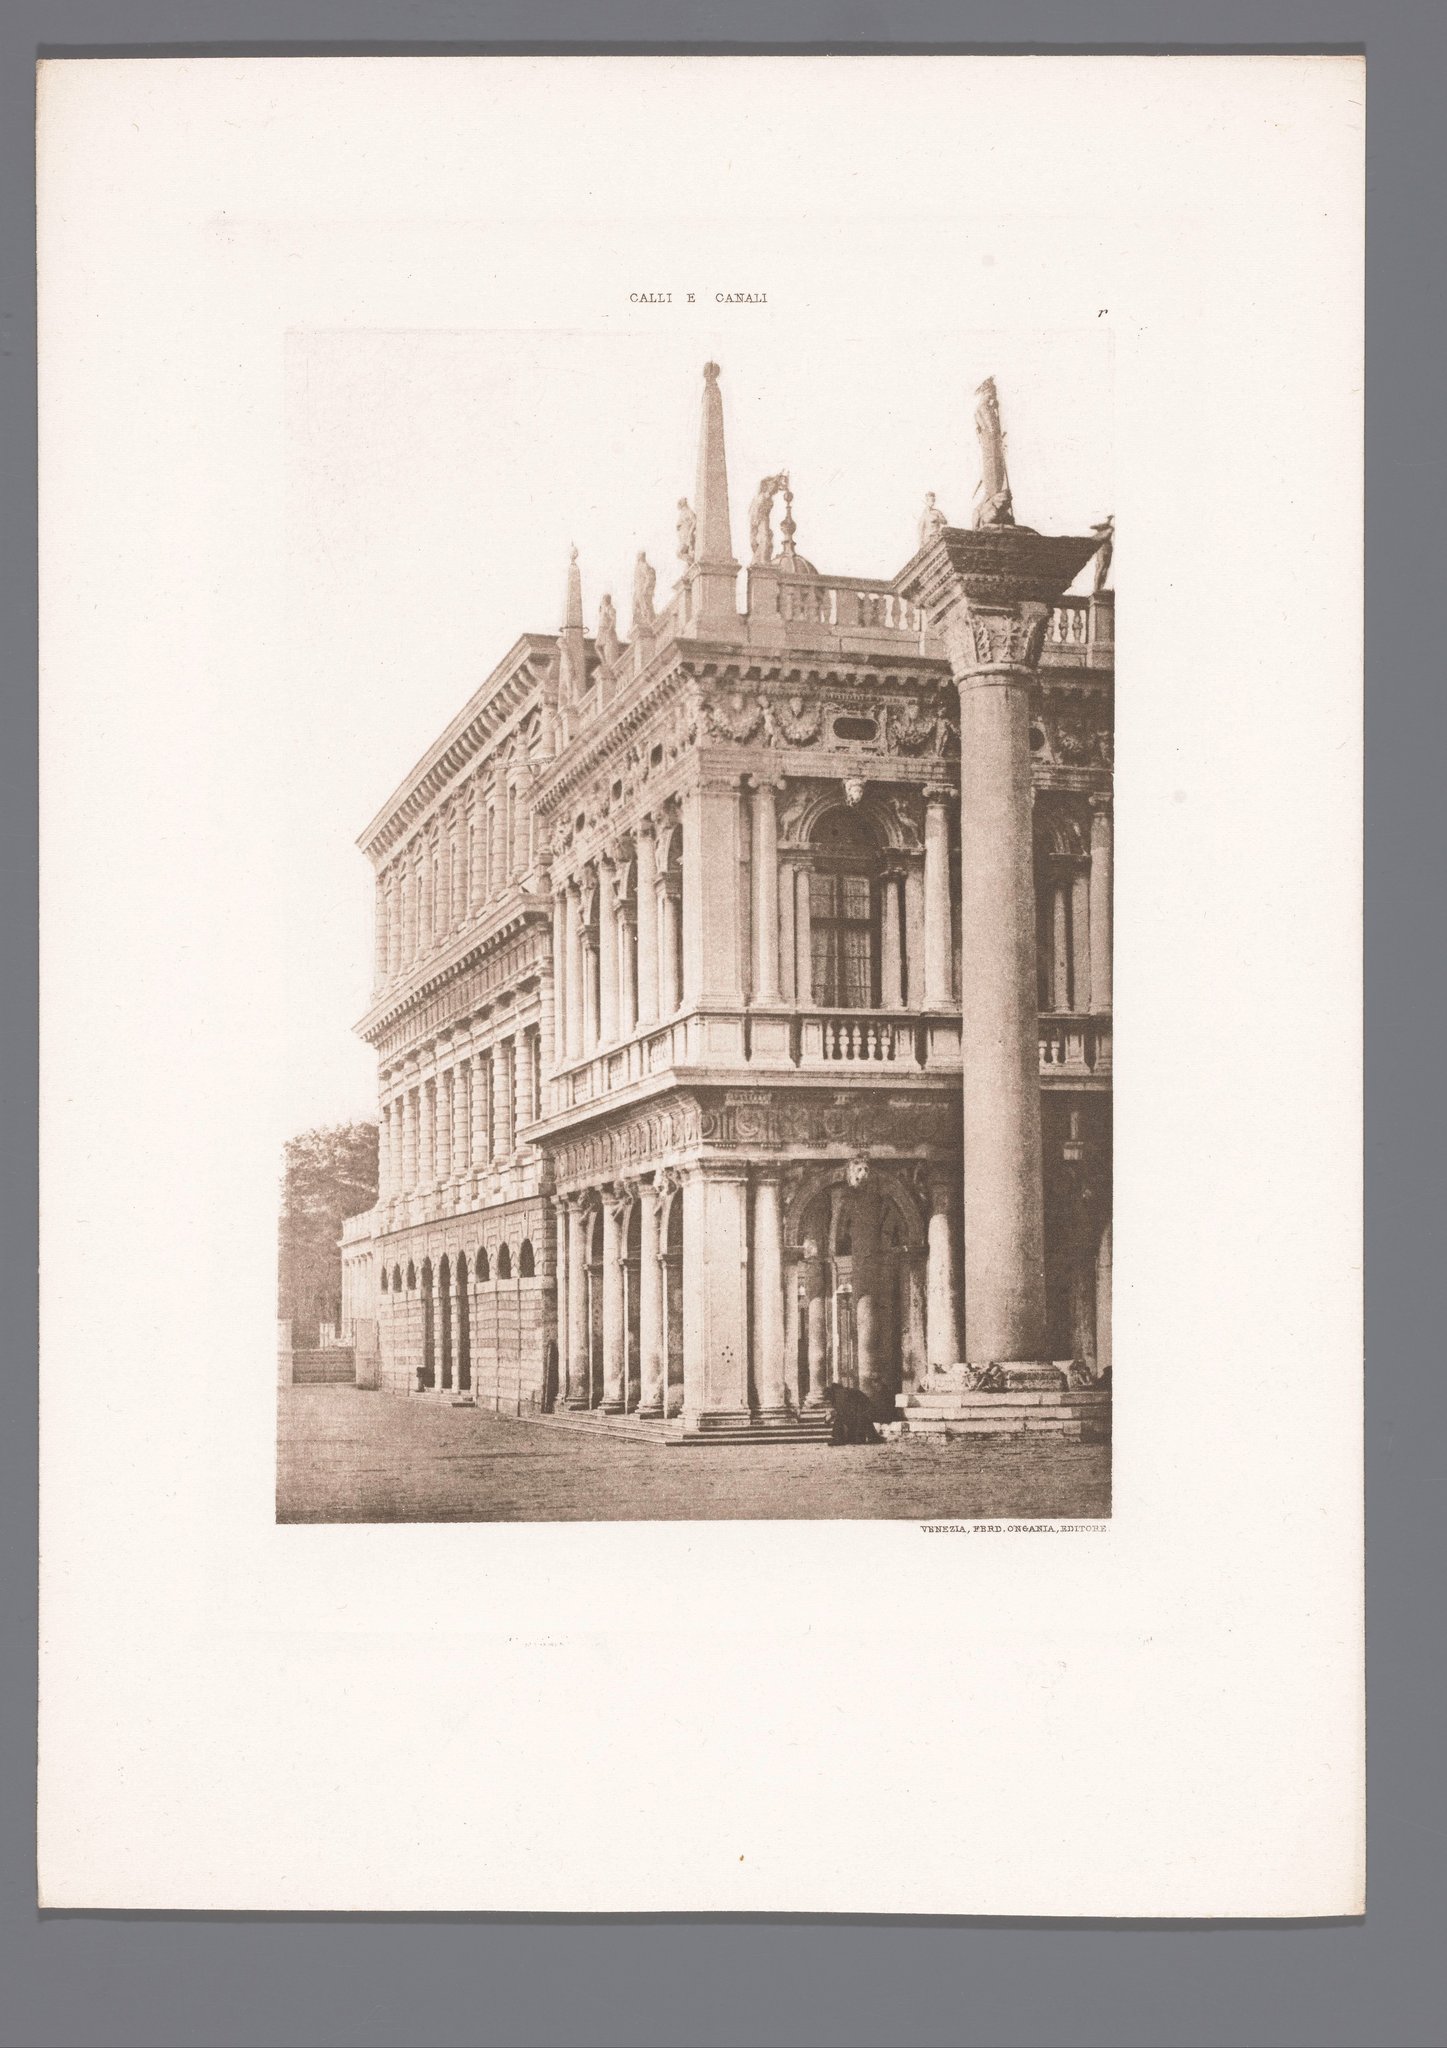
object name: photomechanical print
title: Gezicht op het San Marcoplein in Venetië met de hoek van de Biblioteca Marciana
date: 1888-1898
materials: paper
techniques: photoaquatint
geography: san marco square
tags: colonnade, column, pillar ~ architecture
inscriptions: inscription: ‘r’